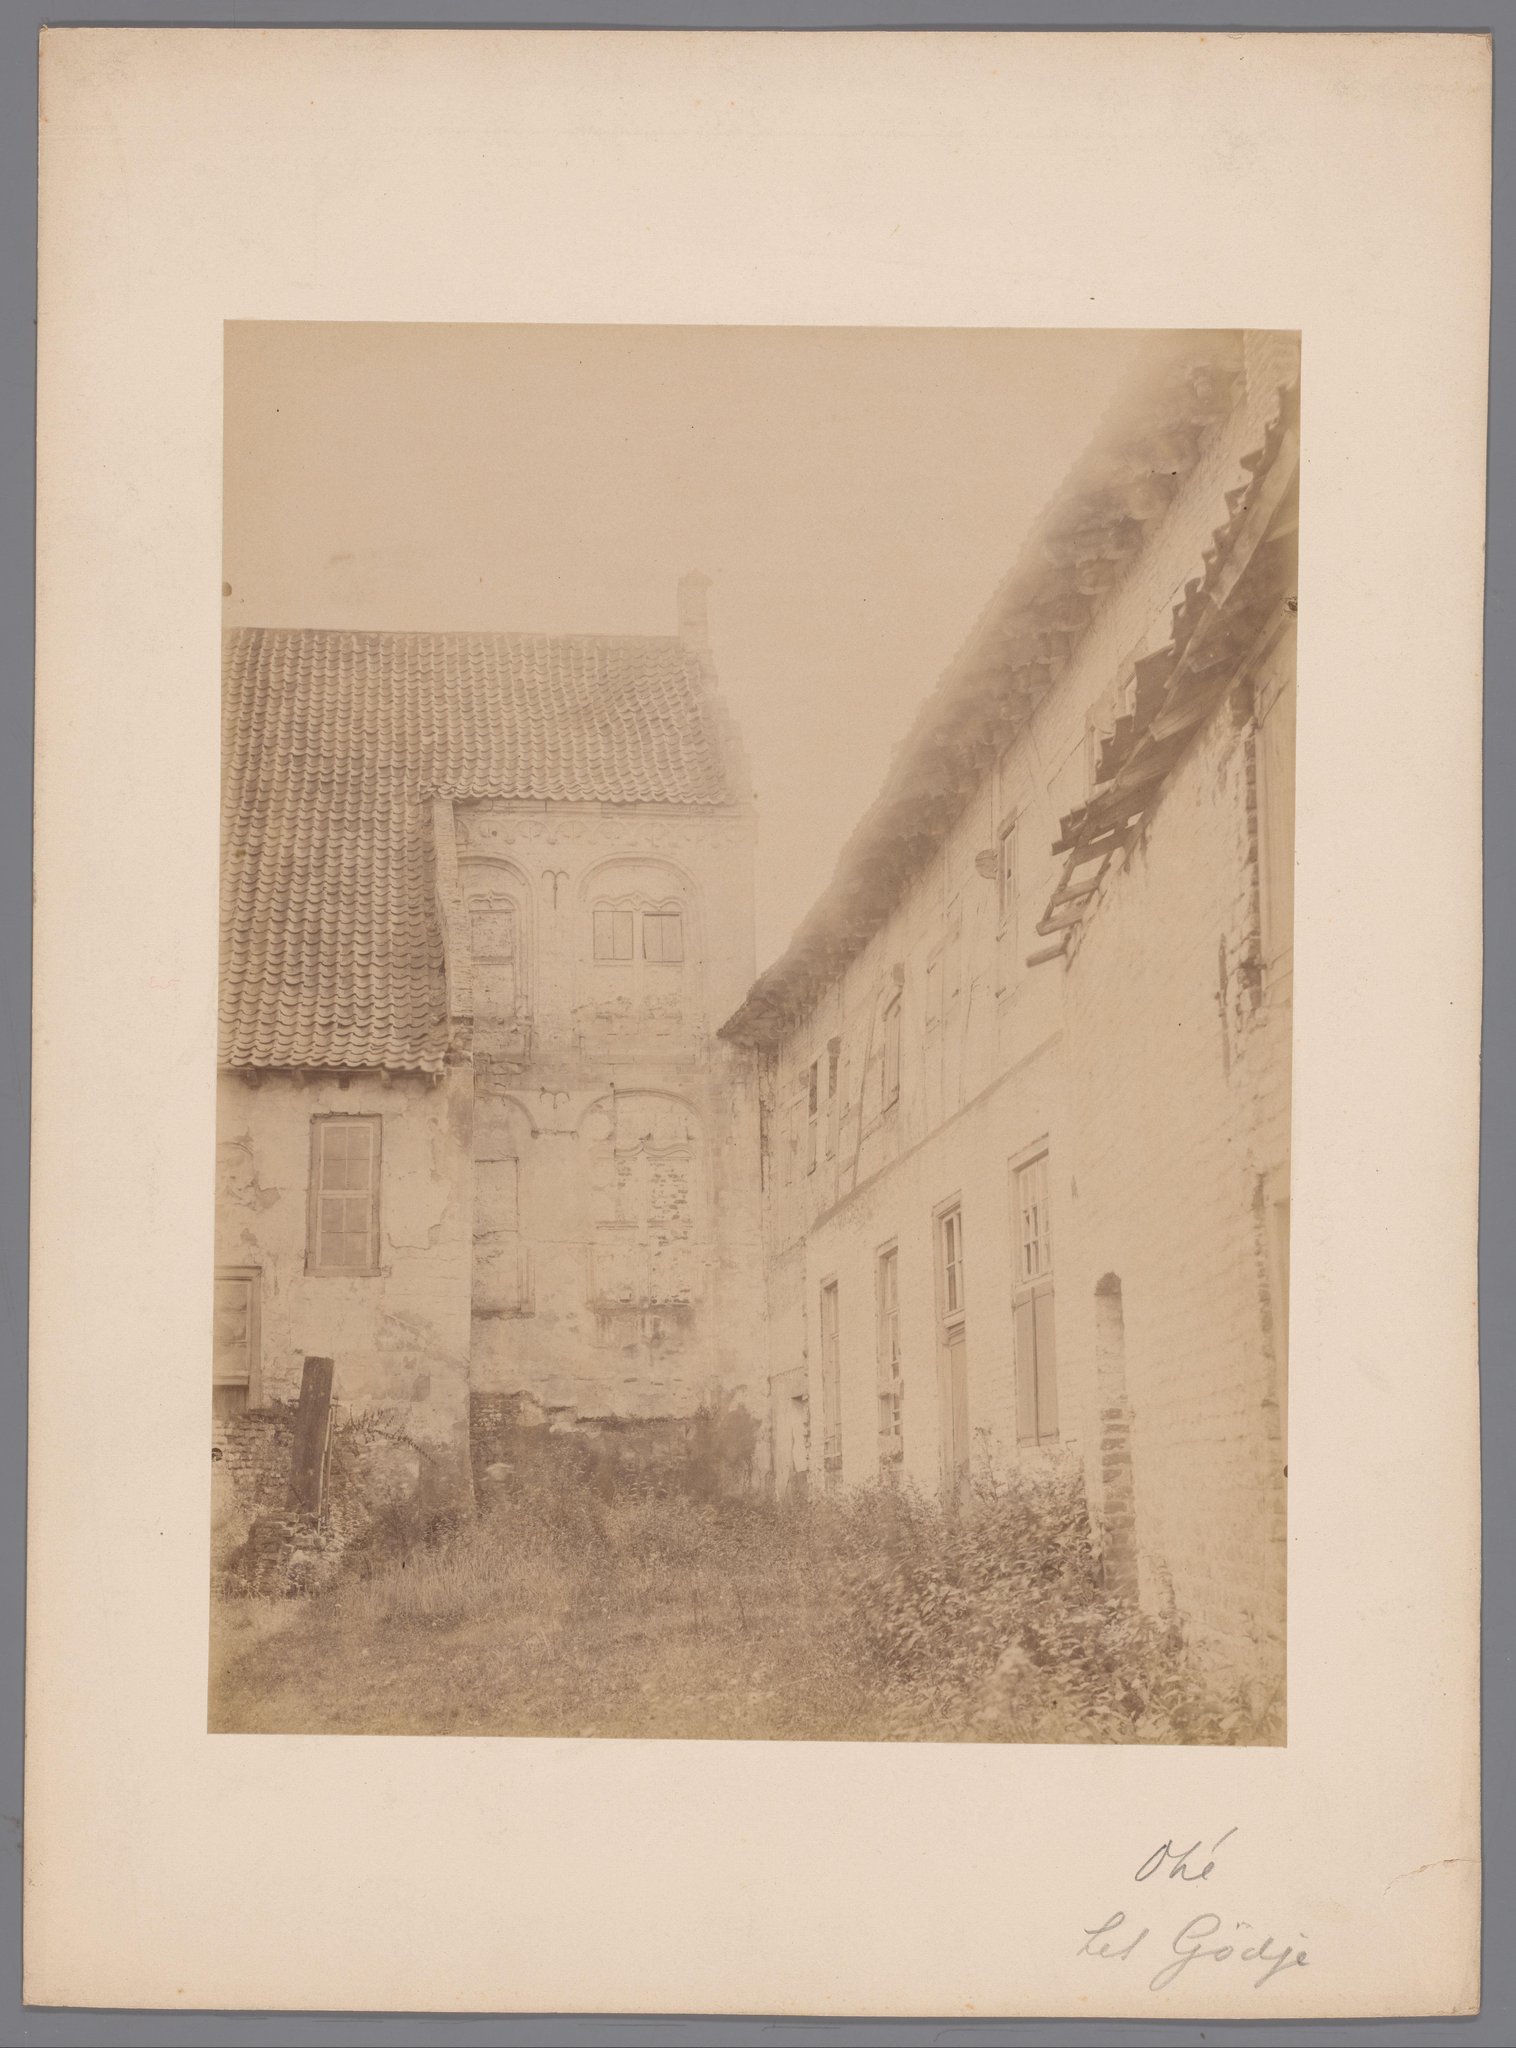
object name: photograph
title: Binnenplaats van Kasteel het Geudje te Ohé en Laak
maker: anoniem (monumentenzorg)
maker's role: fotograaf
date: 1896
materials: cardboard, photographic support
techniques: albumen print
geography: ohé en laak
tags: castle, courtyard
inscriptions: annotation: ‘Ohé/ het Gödje’, annotation: ‘Het huis van Laak genaamd het Gödje op het eiland [...]/ (binnenplaats) aug 1896’